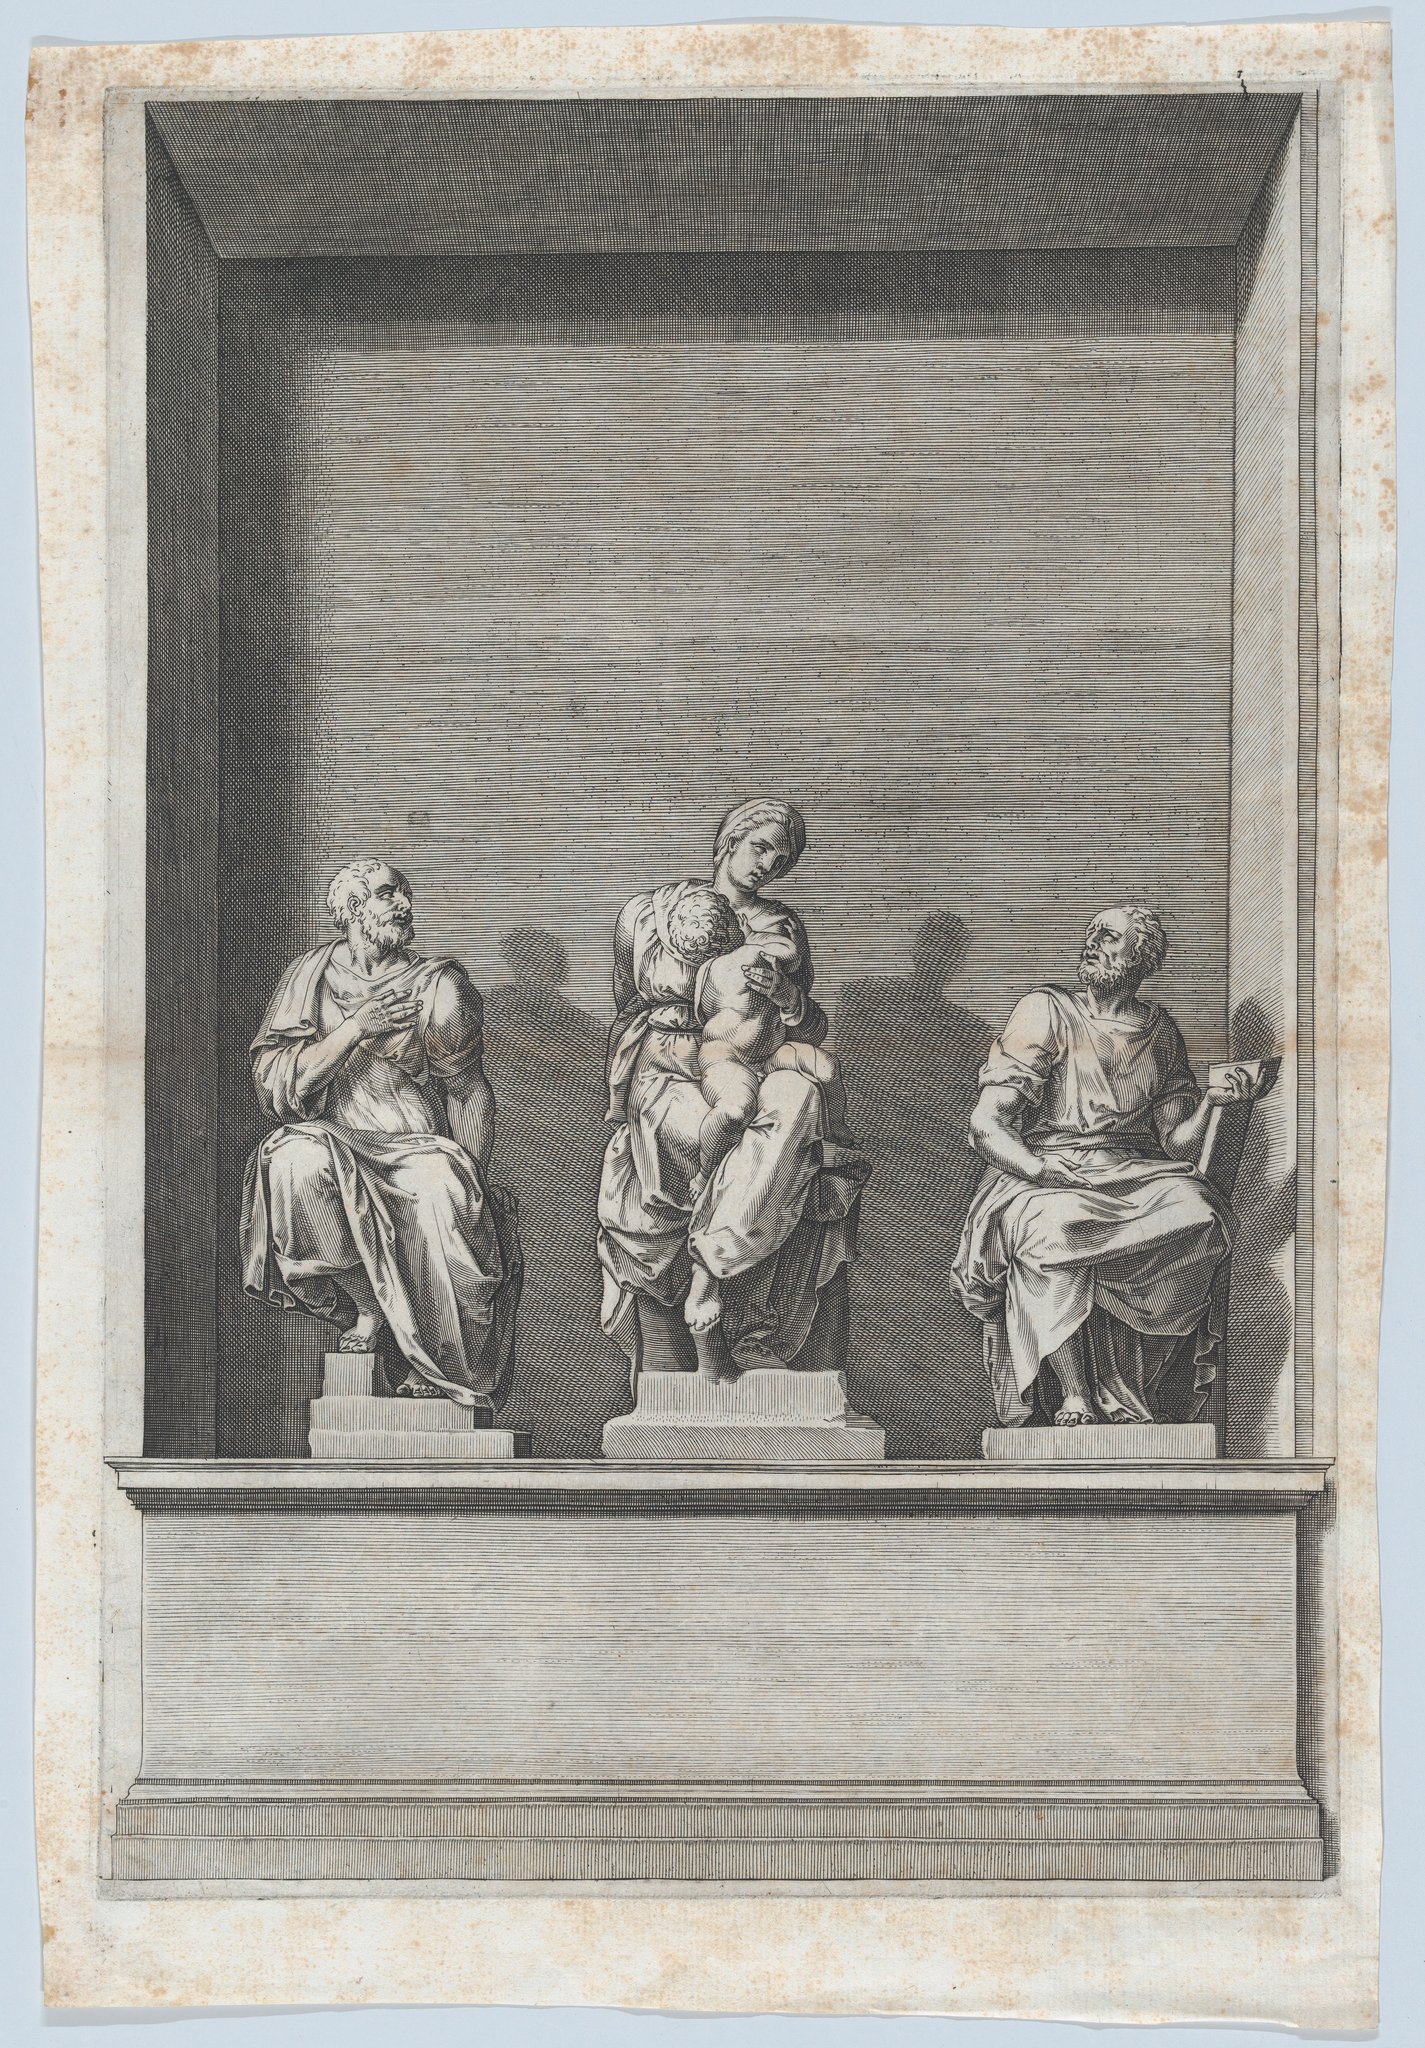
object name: print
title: Madonna and Child Between St Comas and St Damian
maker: cornelis cort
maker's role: artist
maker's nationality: netherlandish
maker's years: 1533-1578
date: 1570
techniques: engraving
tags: madonna and child,saints